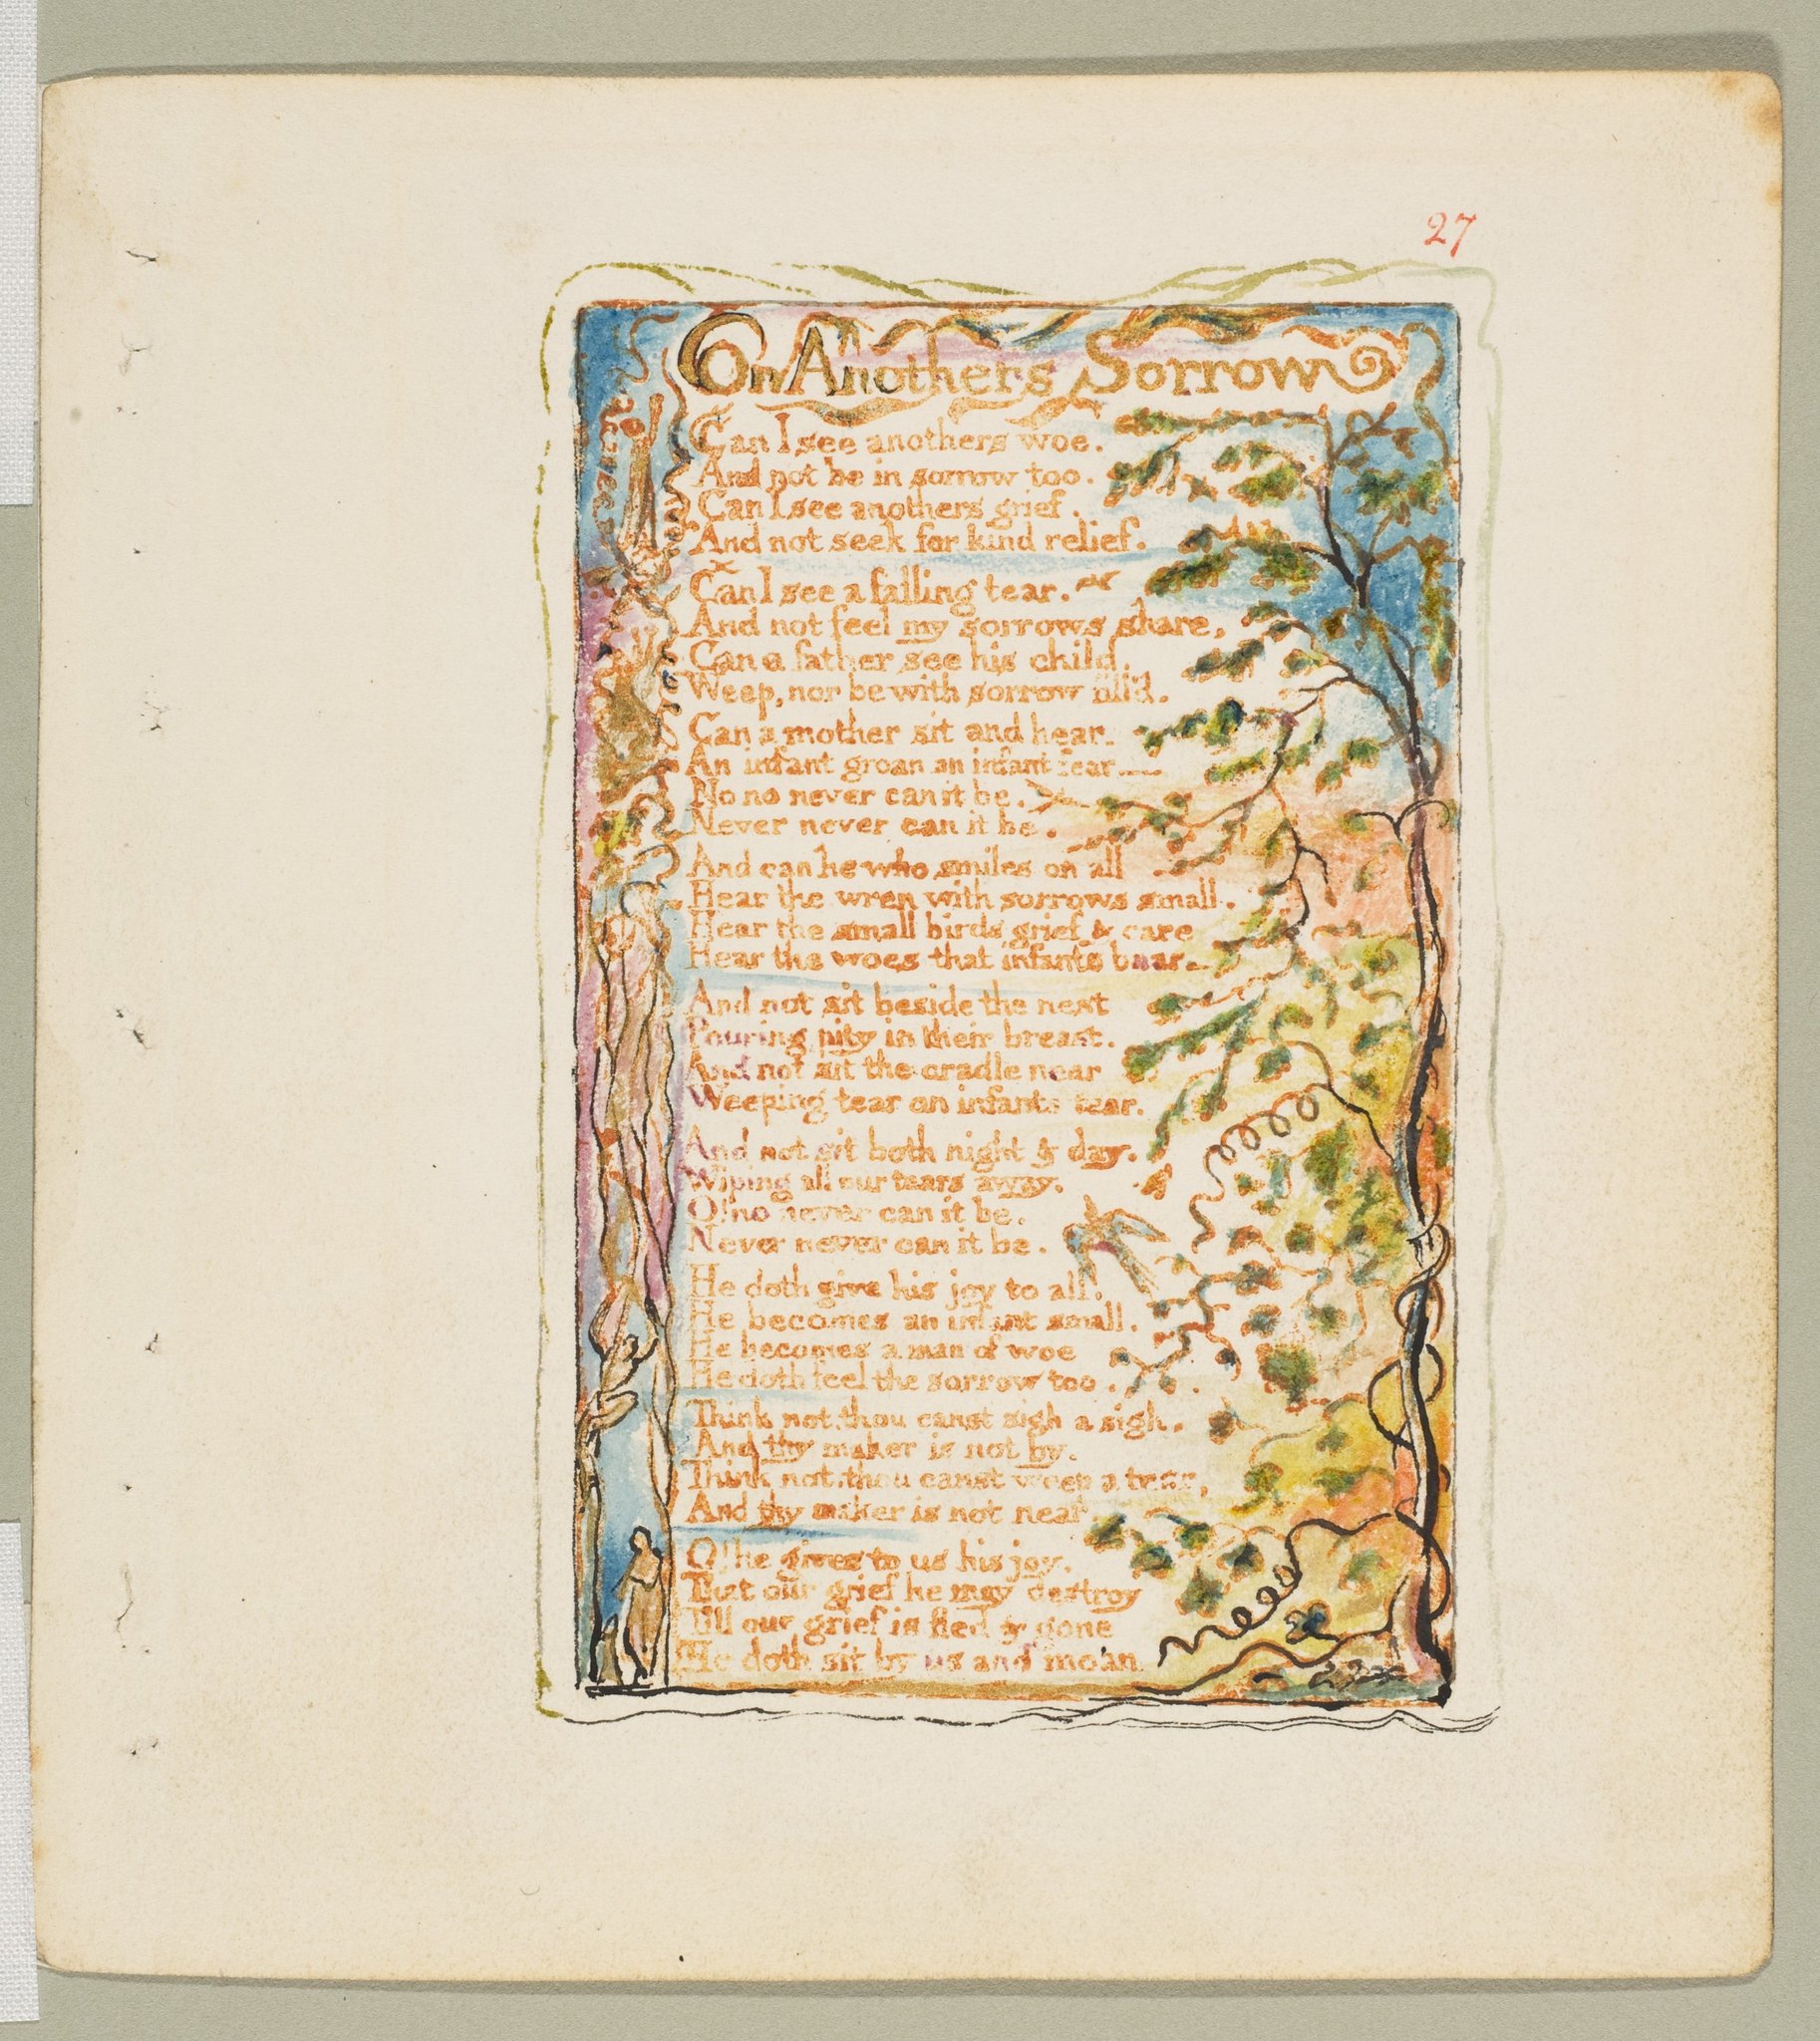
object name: print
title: Songs of Innocence: On Anothers Sorrow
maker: william blake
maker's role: artist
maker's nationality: british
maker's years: 1757-1827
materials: gold, ink, shell, watercolor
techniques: etching, hand coloring, printing, relief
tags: poetry,trees